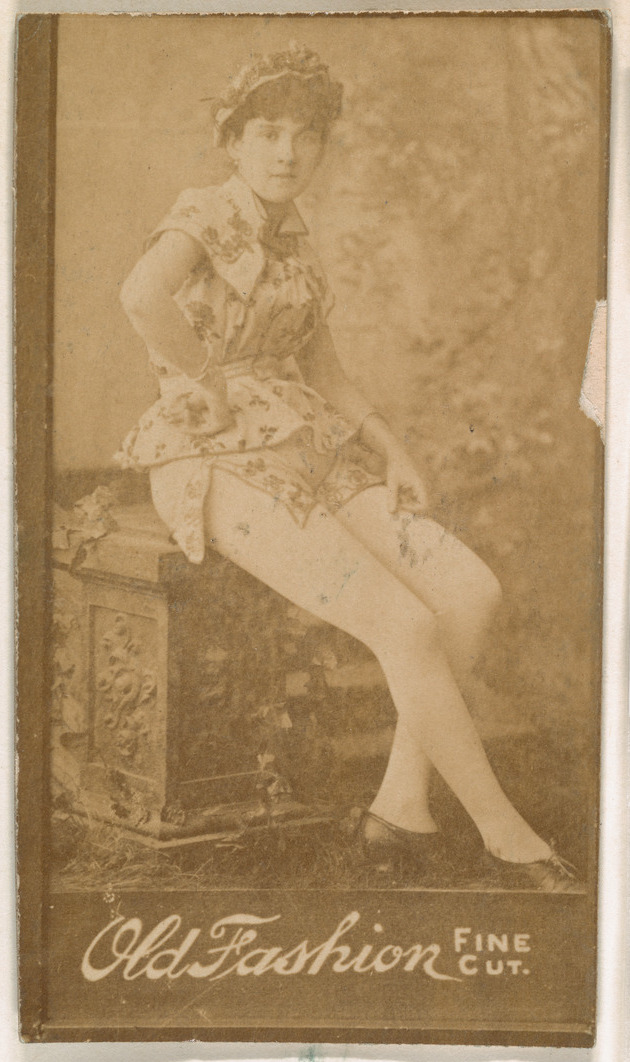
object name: photograph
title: Actress seated on bench, from the Actresses series (N664) promoting Old Fashion Fine Cut Tobacco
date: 1888-1890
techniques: albumen silver print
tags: portraits,women,actresses